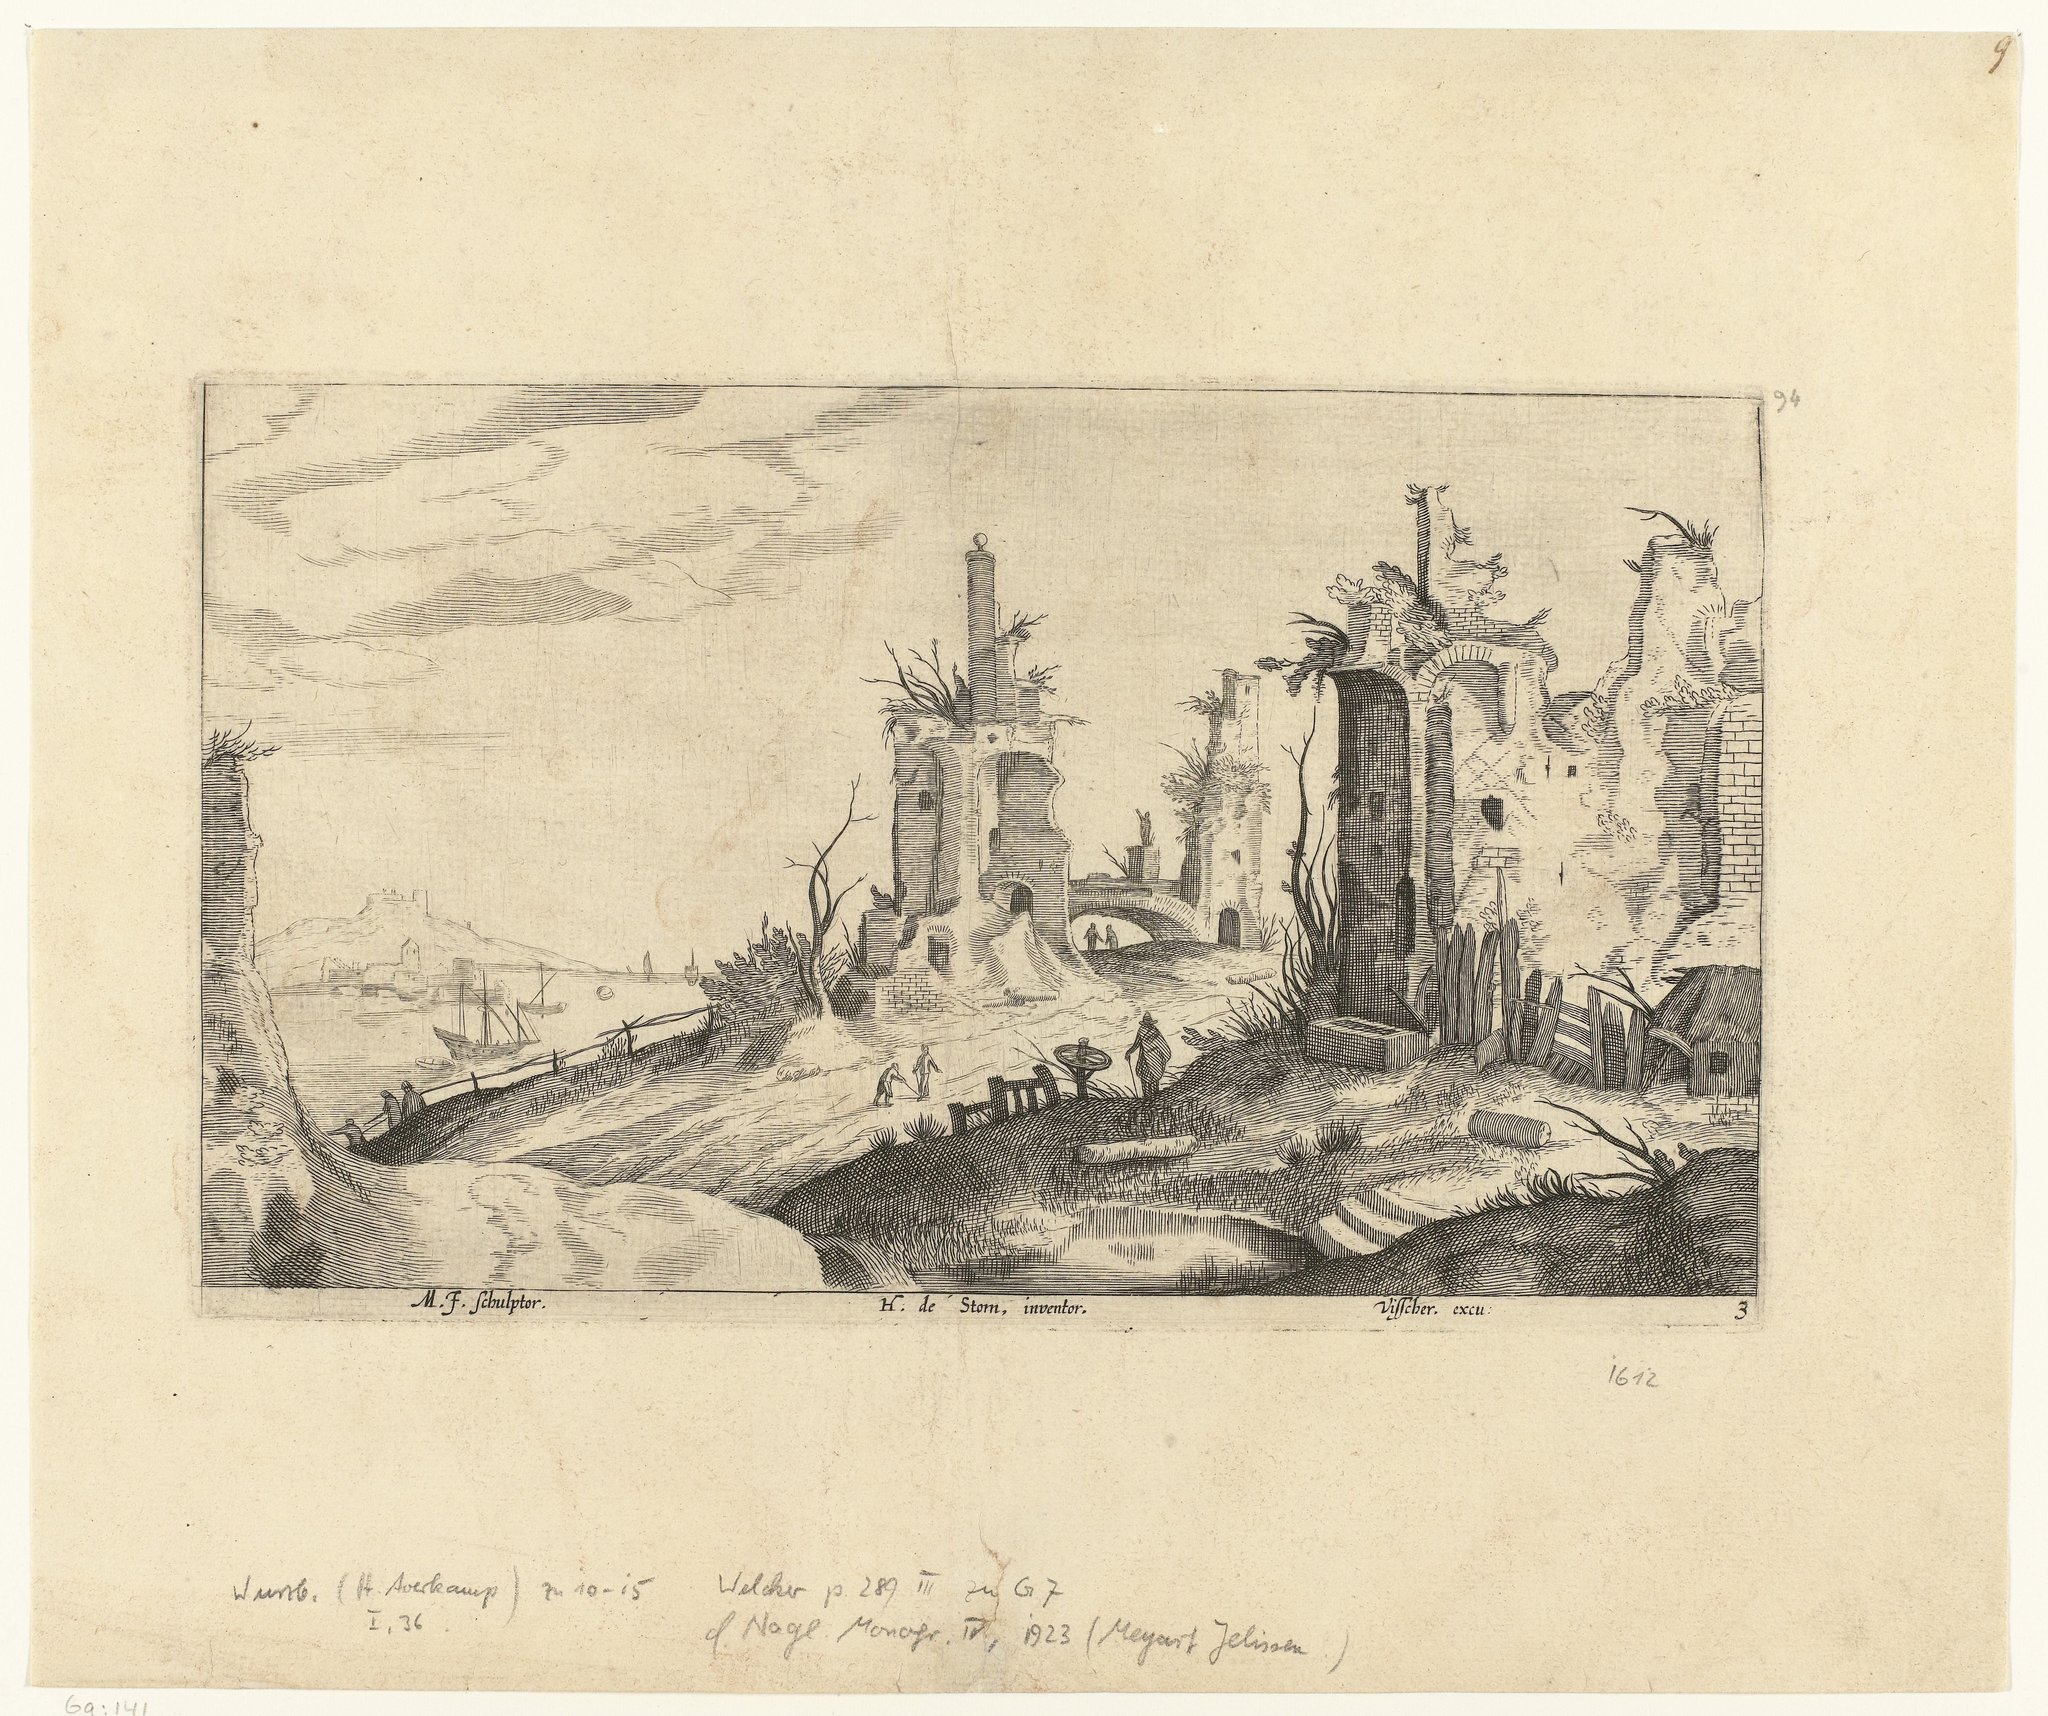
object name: print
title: Landschap met antieke ruïnes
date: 1610-1614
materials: paper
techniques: engraving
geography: amsterdam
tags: landscape with ruins - ii - ideal landscapes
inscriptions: inscription: ‘9’, collector's mark: Lugt 2760, collector's mark: Lugt 2228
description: Heuvelachtig landschap met antieke ruïnes en diverse figuren. Op de achtergrond schepen op het water. Prent uit een serie van zes met landschappen.